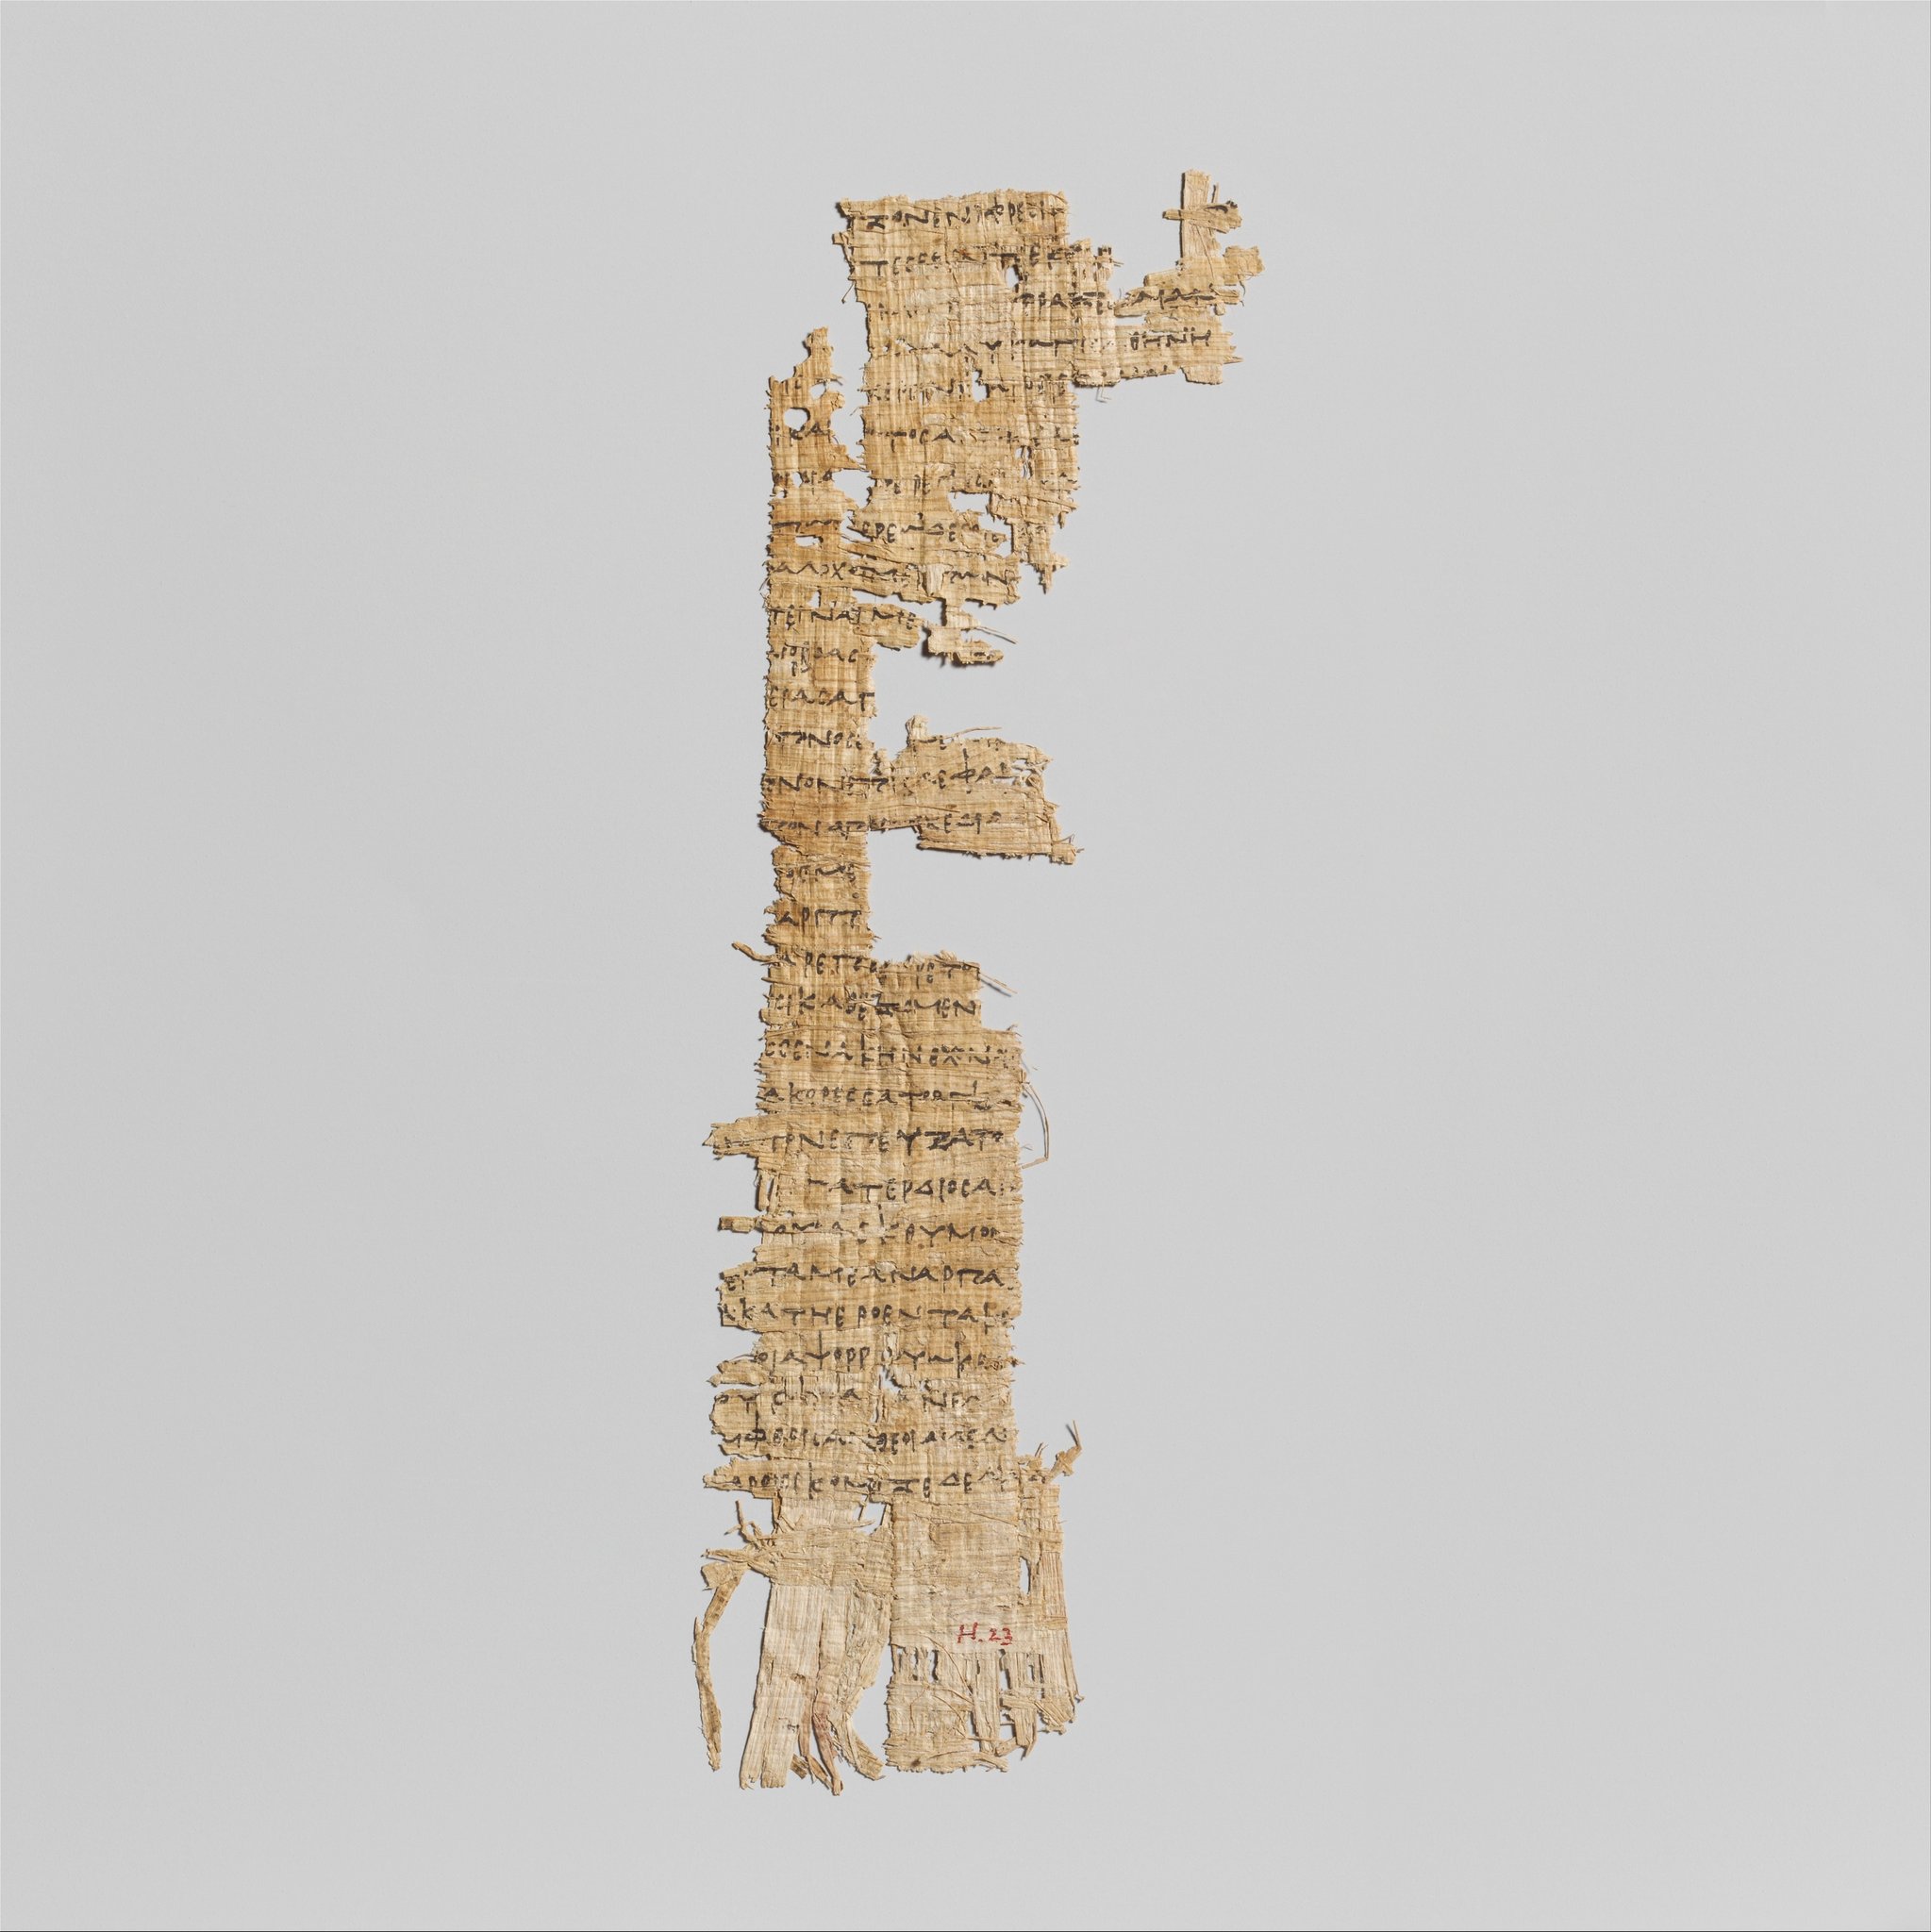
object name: papyrus fragment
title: Papyrus fragment with lines from Homer's Odyssey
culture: greek, ptolemaic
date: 285-250 BCE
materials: papyrus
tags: poetry